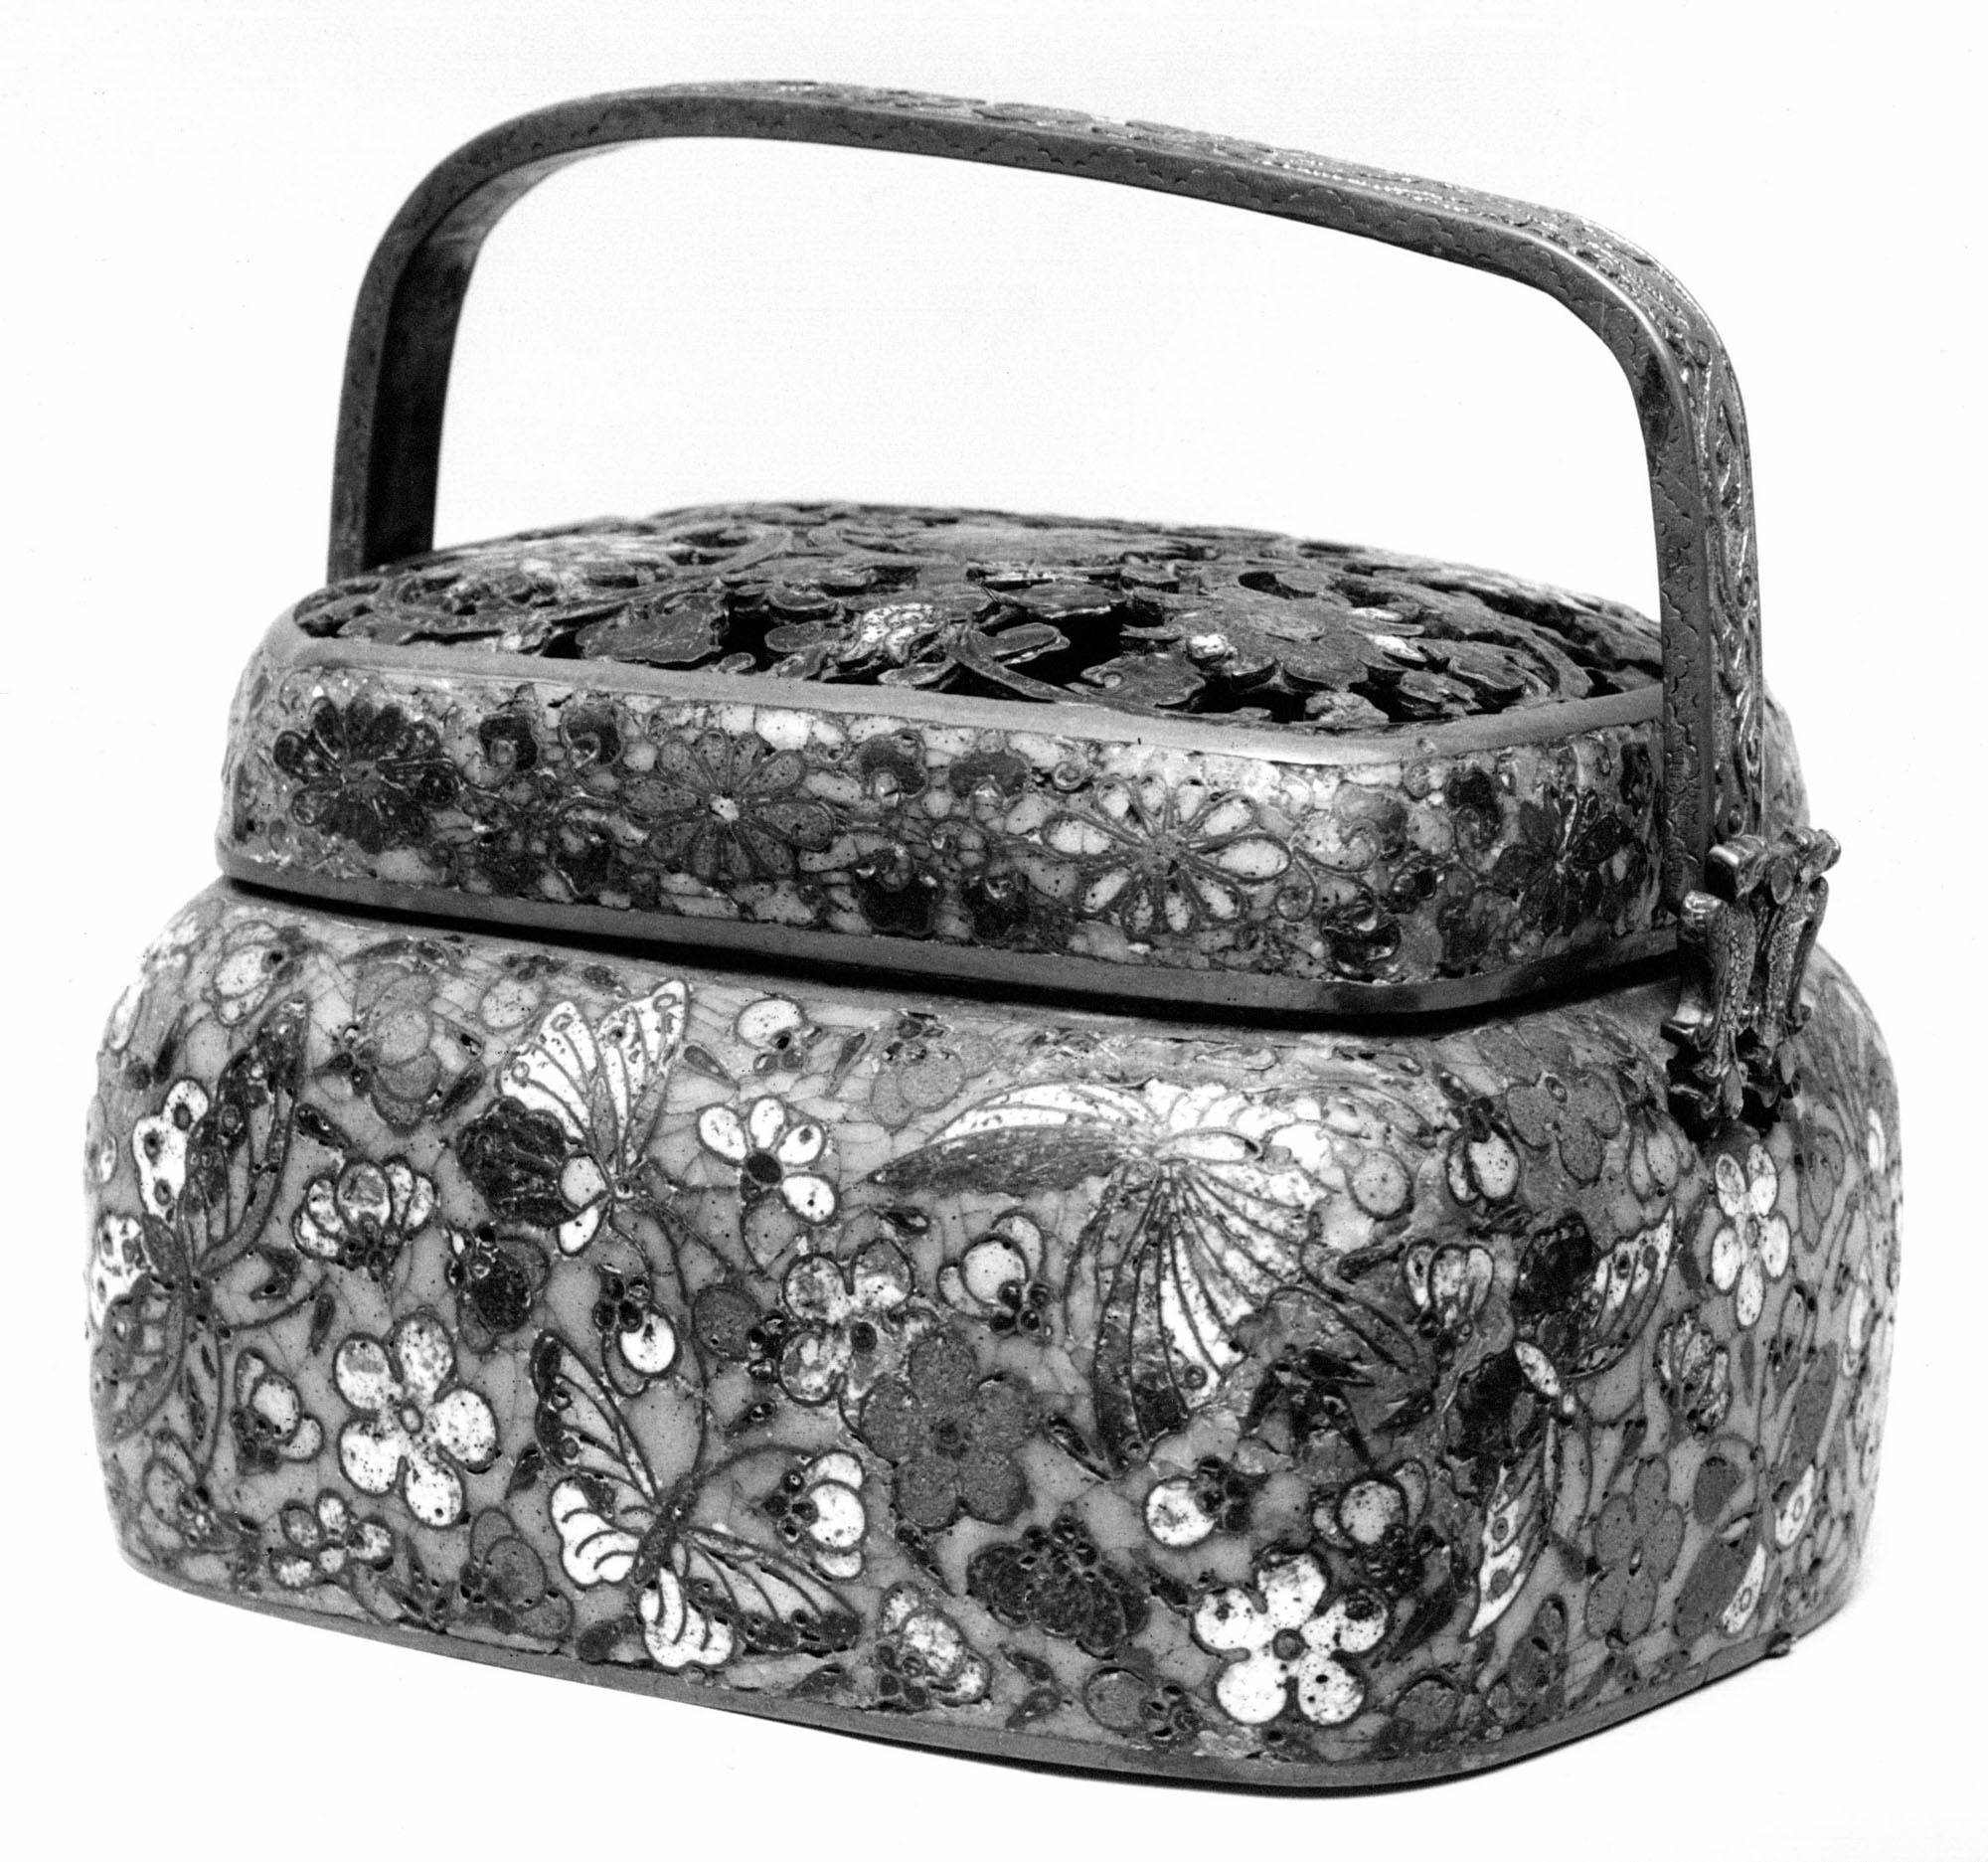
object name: hand warmer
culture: chinese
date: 1567-1633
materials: enamel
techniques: enamel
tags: butterflies,plants